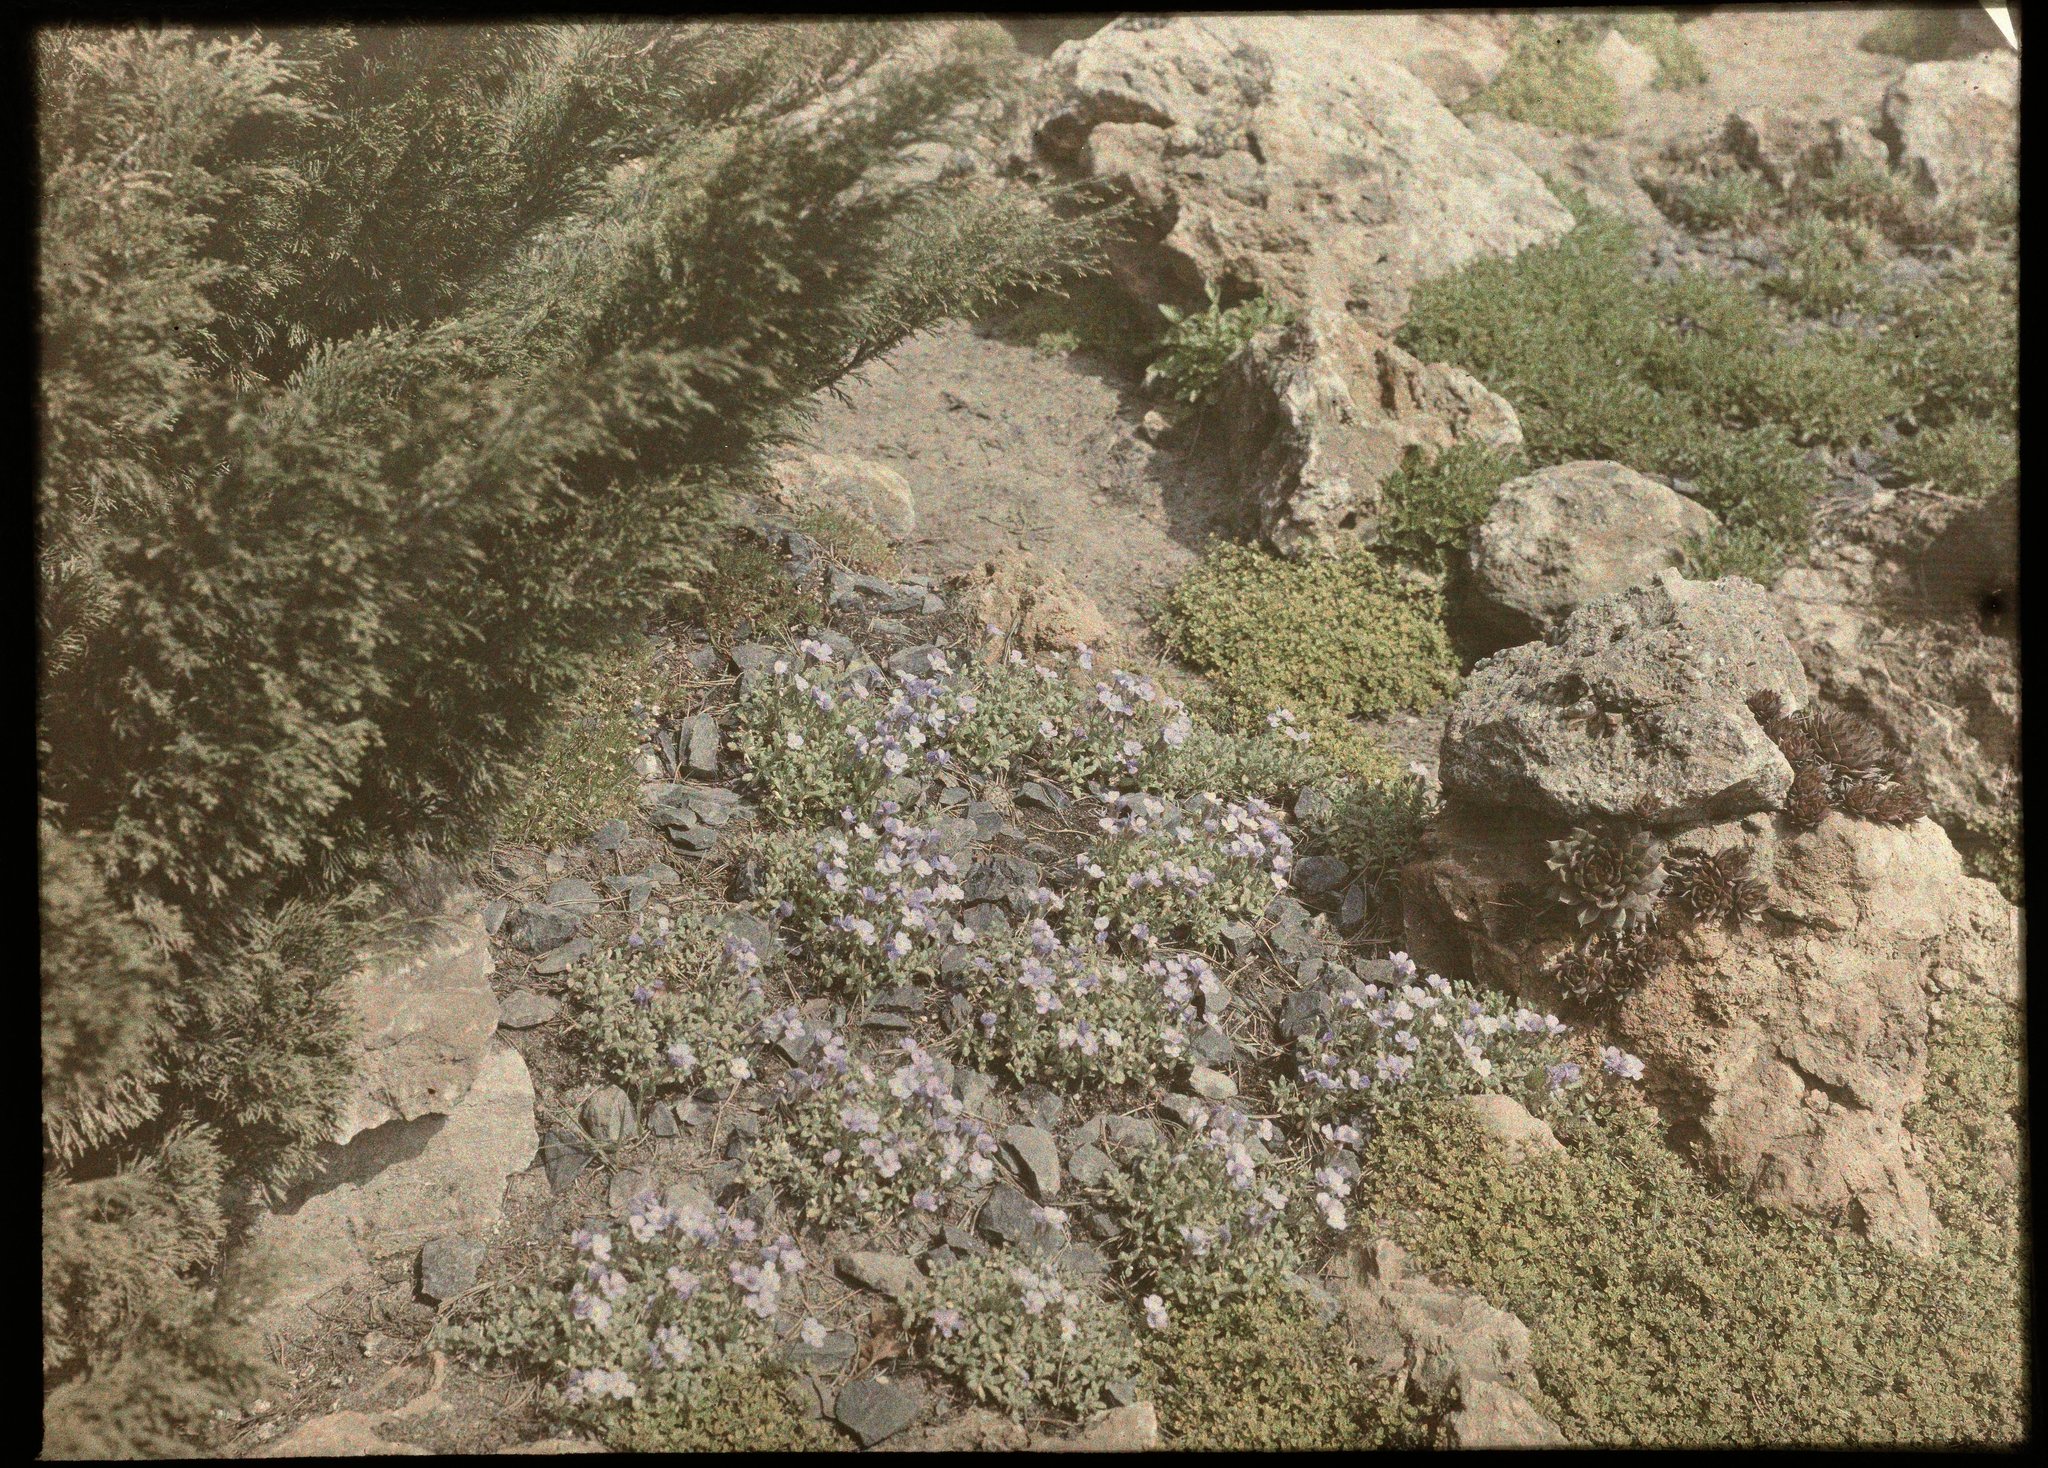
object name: color slide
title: Bloemen op steen-/rotsbodem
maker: adolphe burdet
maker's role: fotograaf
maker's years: 1860-1940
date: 1907-1930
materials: glass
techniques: autochrome process, slide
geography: netherlands